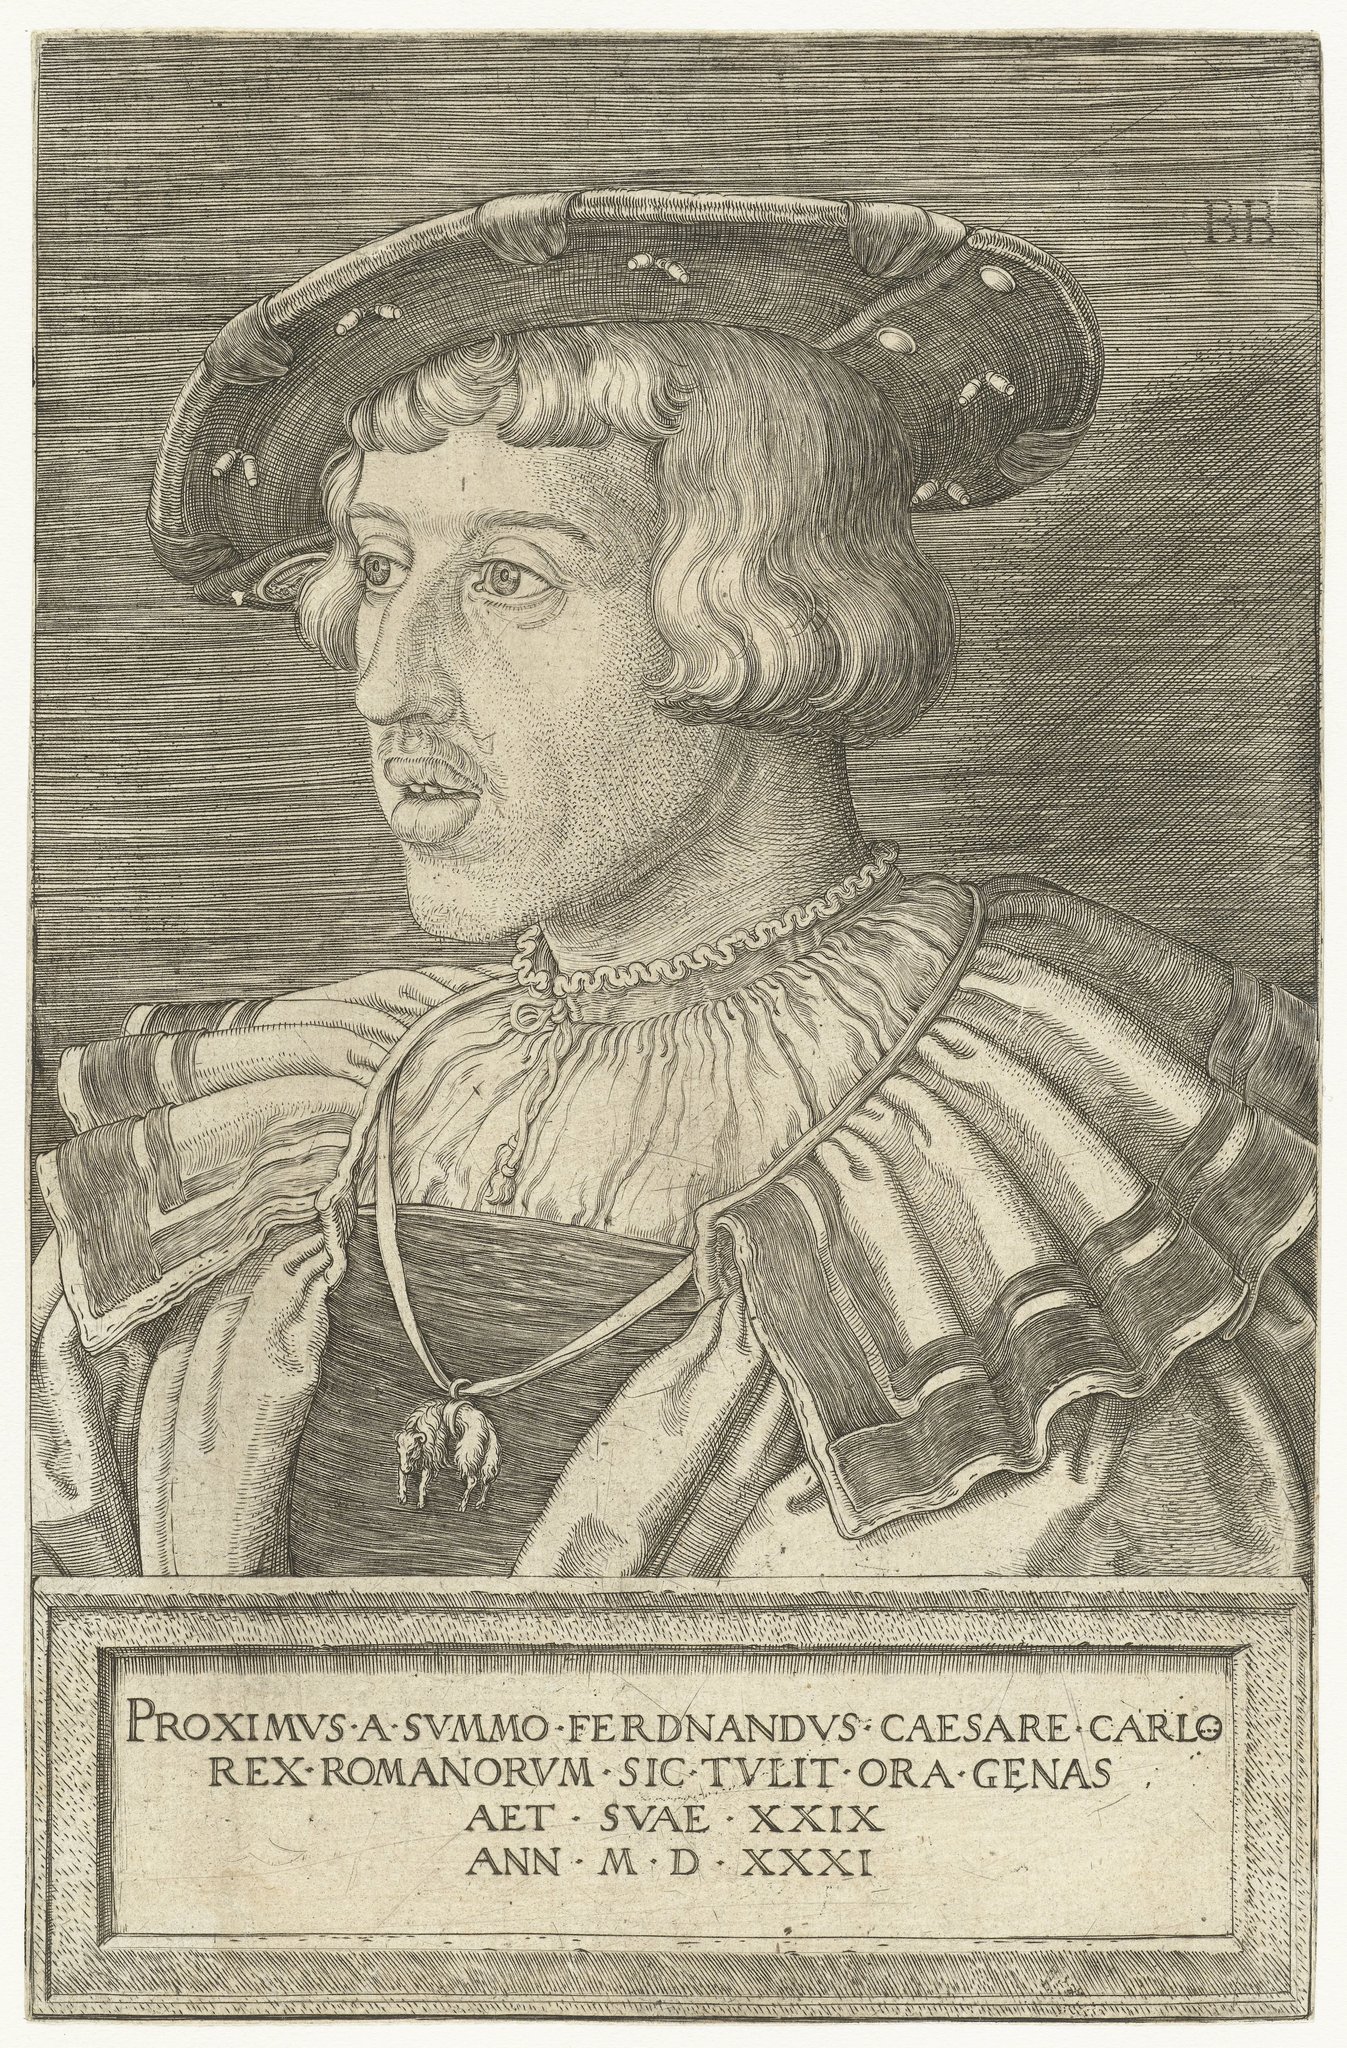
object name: print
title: Portret van keizer Ferdinand I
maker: barthel beham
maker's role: print maker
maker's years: 1502-1540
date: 1531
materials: paper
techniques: engraving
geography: munich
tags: vienna, ferdinand i van habsburg (duits keizer)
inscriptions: collector's mark: Lugt 2228a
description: Portret van Keizer Ferdinand I op 29-jarige leeftijd met Latijns onderschrift dat hem in de traditie plaatst van de Romeinse overheersers.